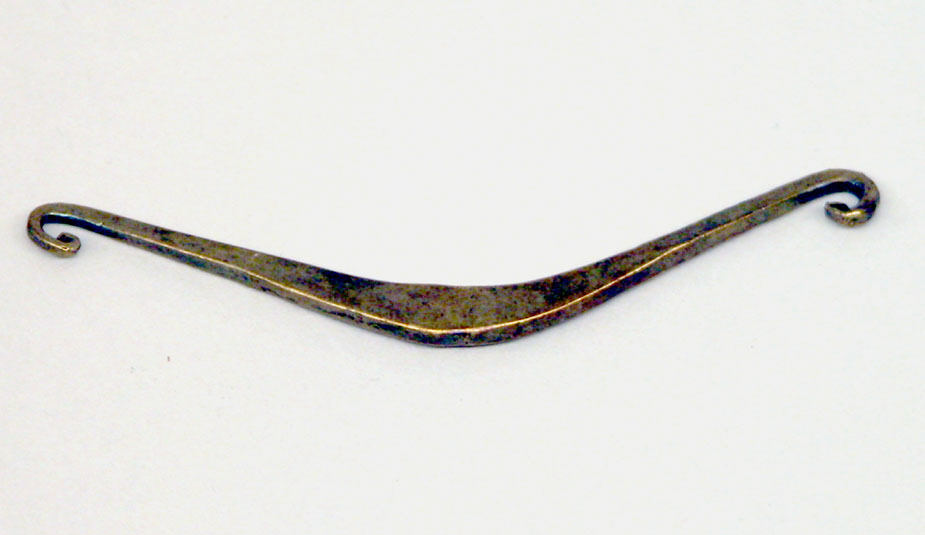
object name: pendant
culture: indonesian, javanese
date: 201-300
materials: gold